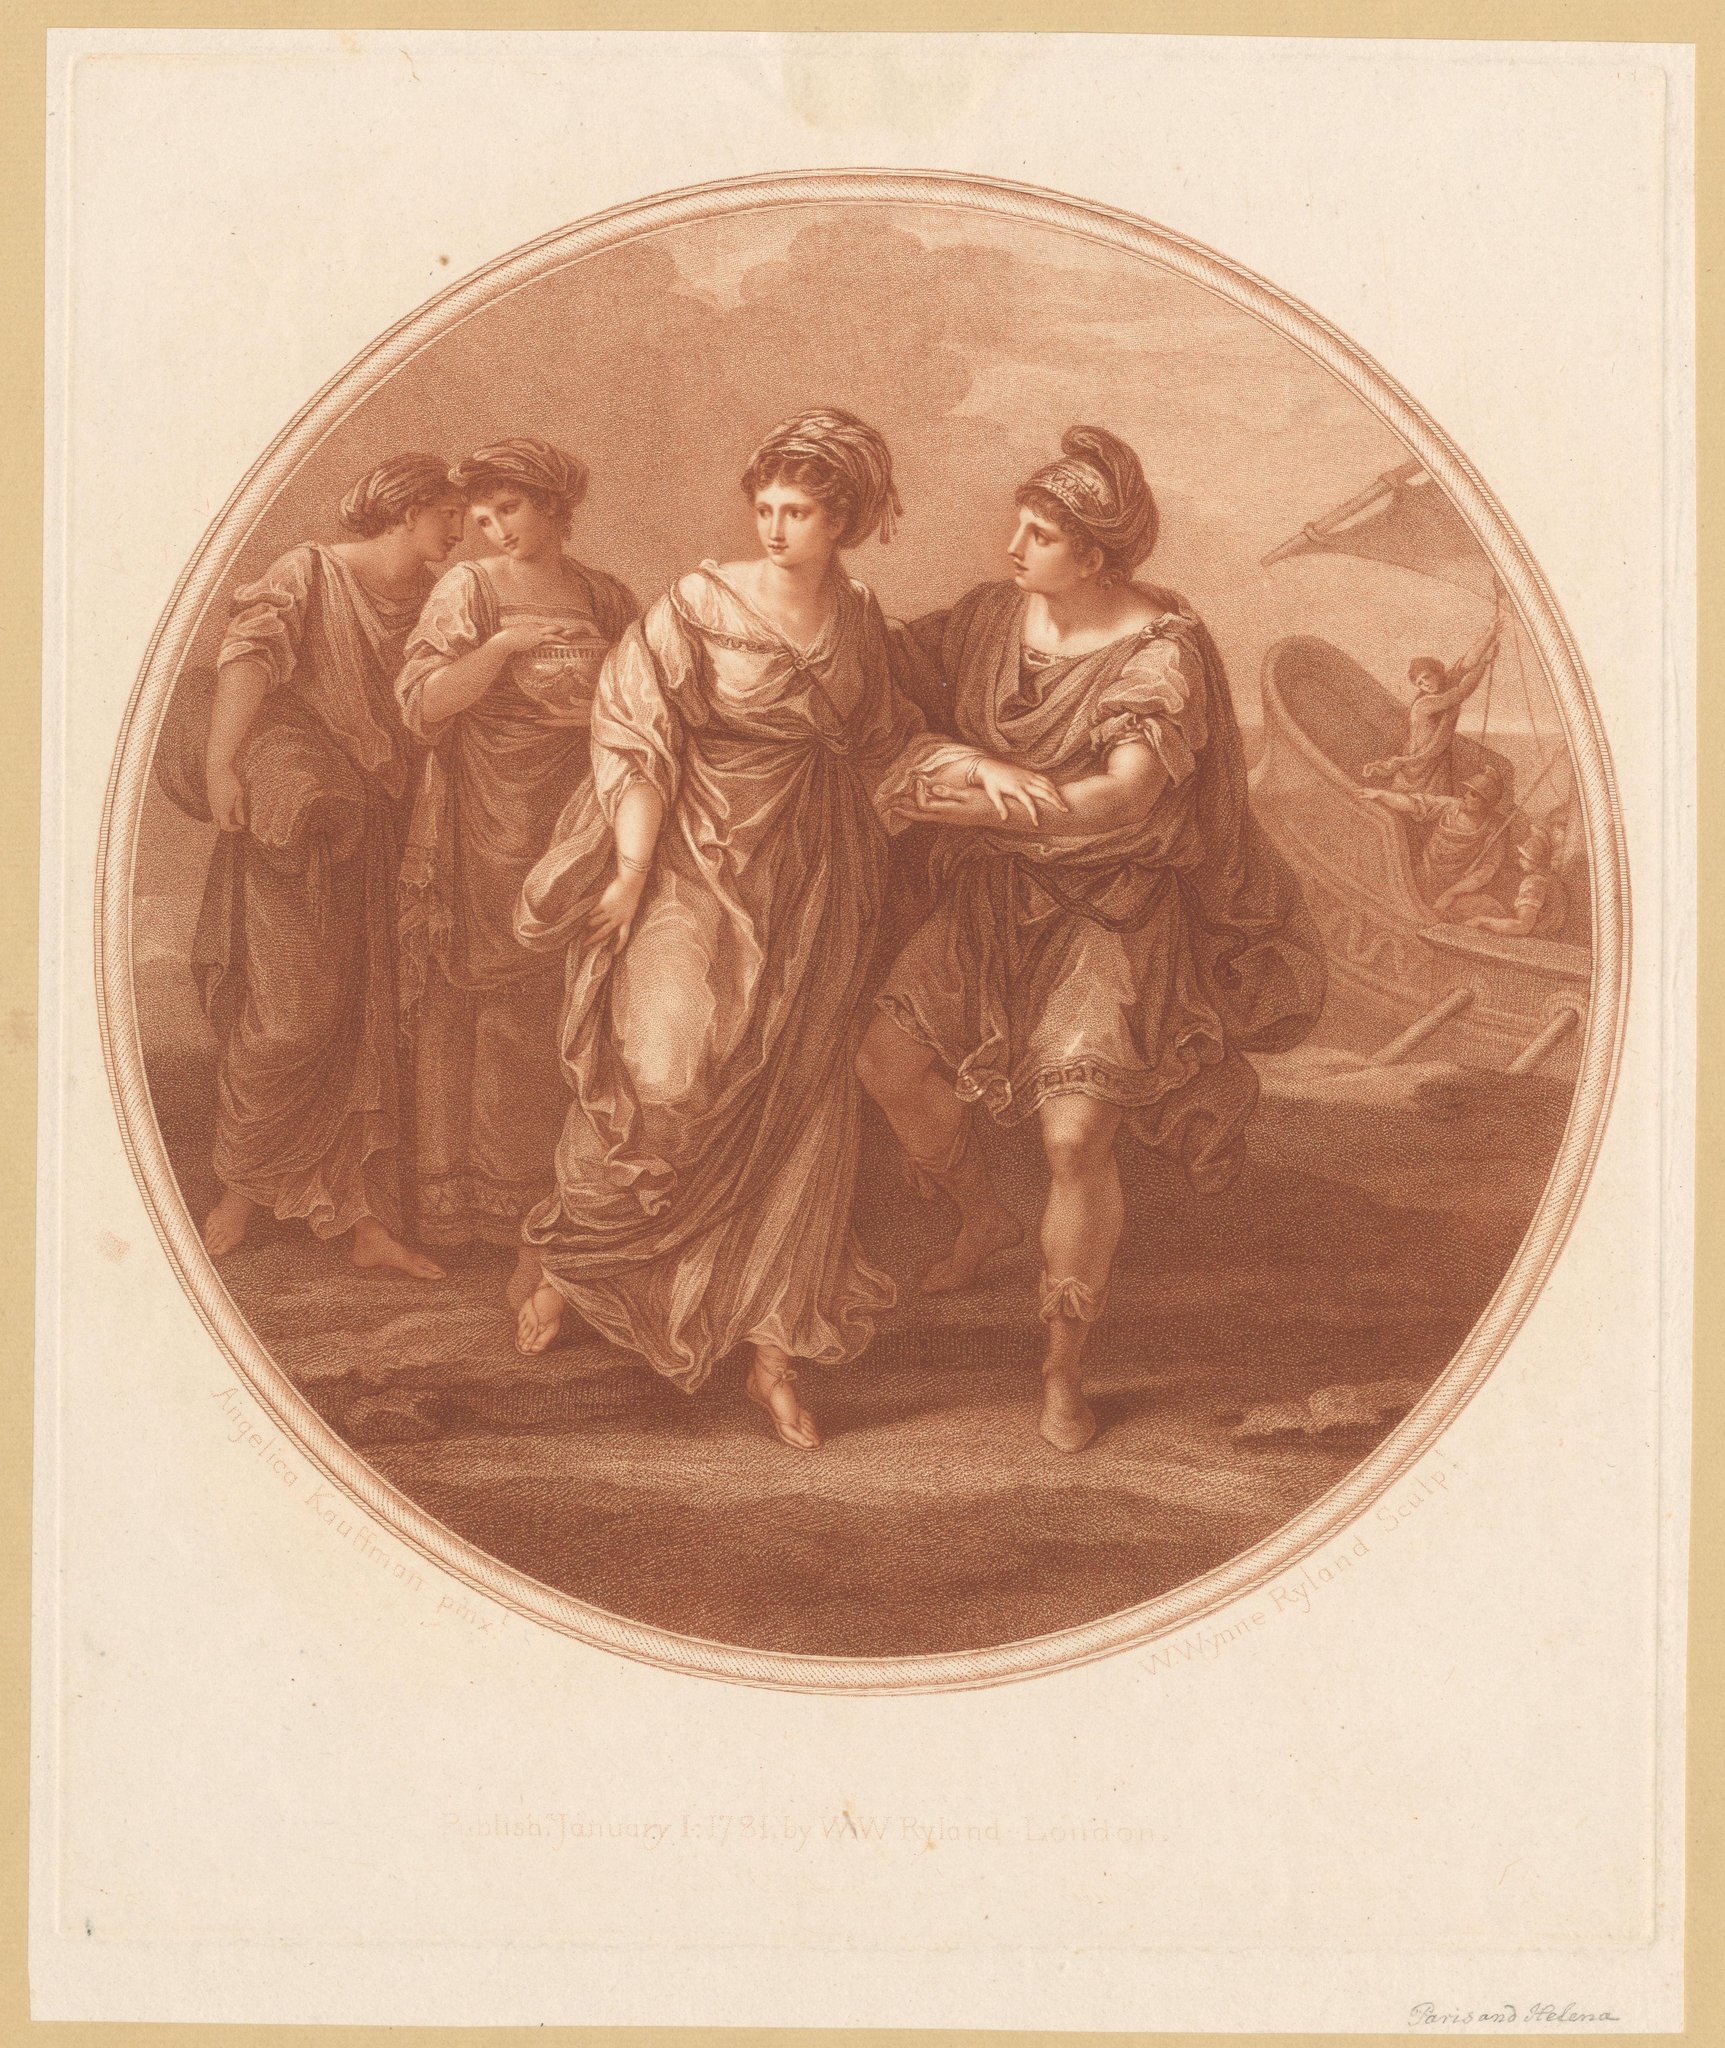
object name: print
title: Ontvoering van Helena van Troje door Paris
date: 1781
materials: paper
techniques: etching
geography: london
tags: the abduction of helen and some of her companions: paris carries them off by sea, and takes a part of the palace-treasure with him